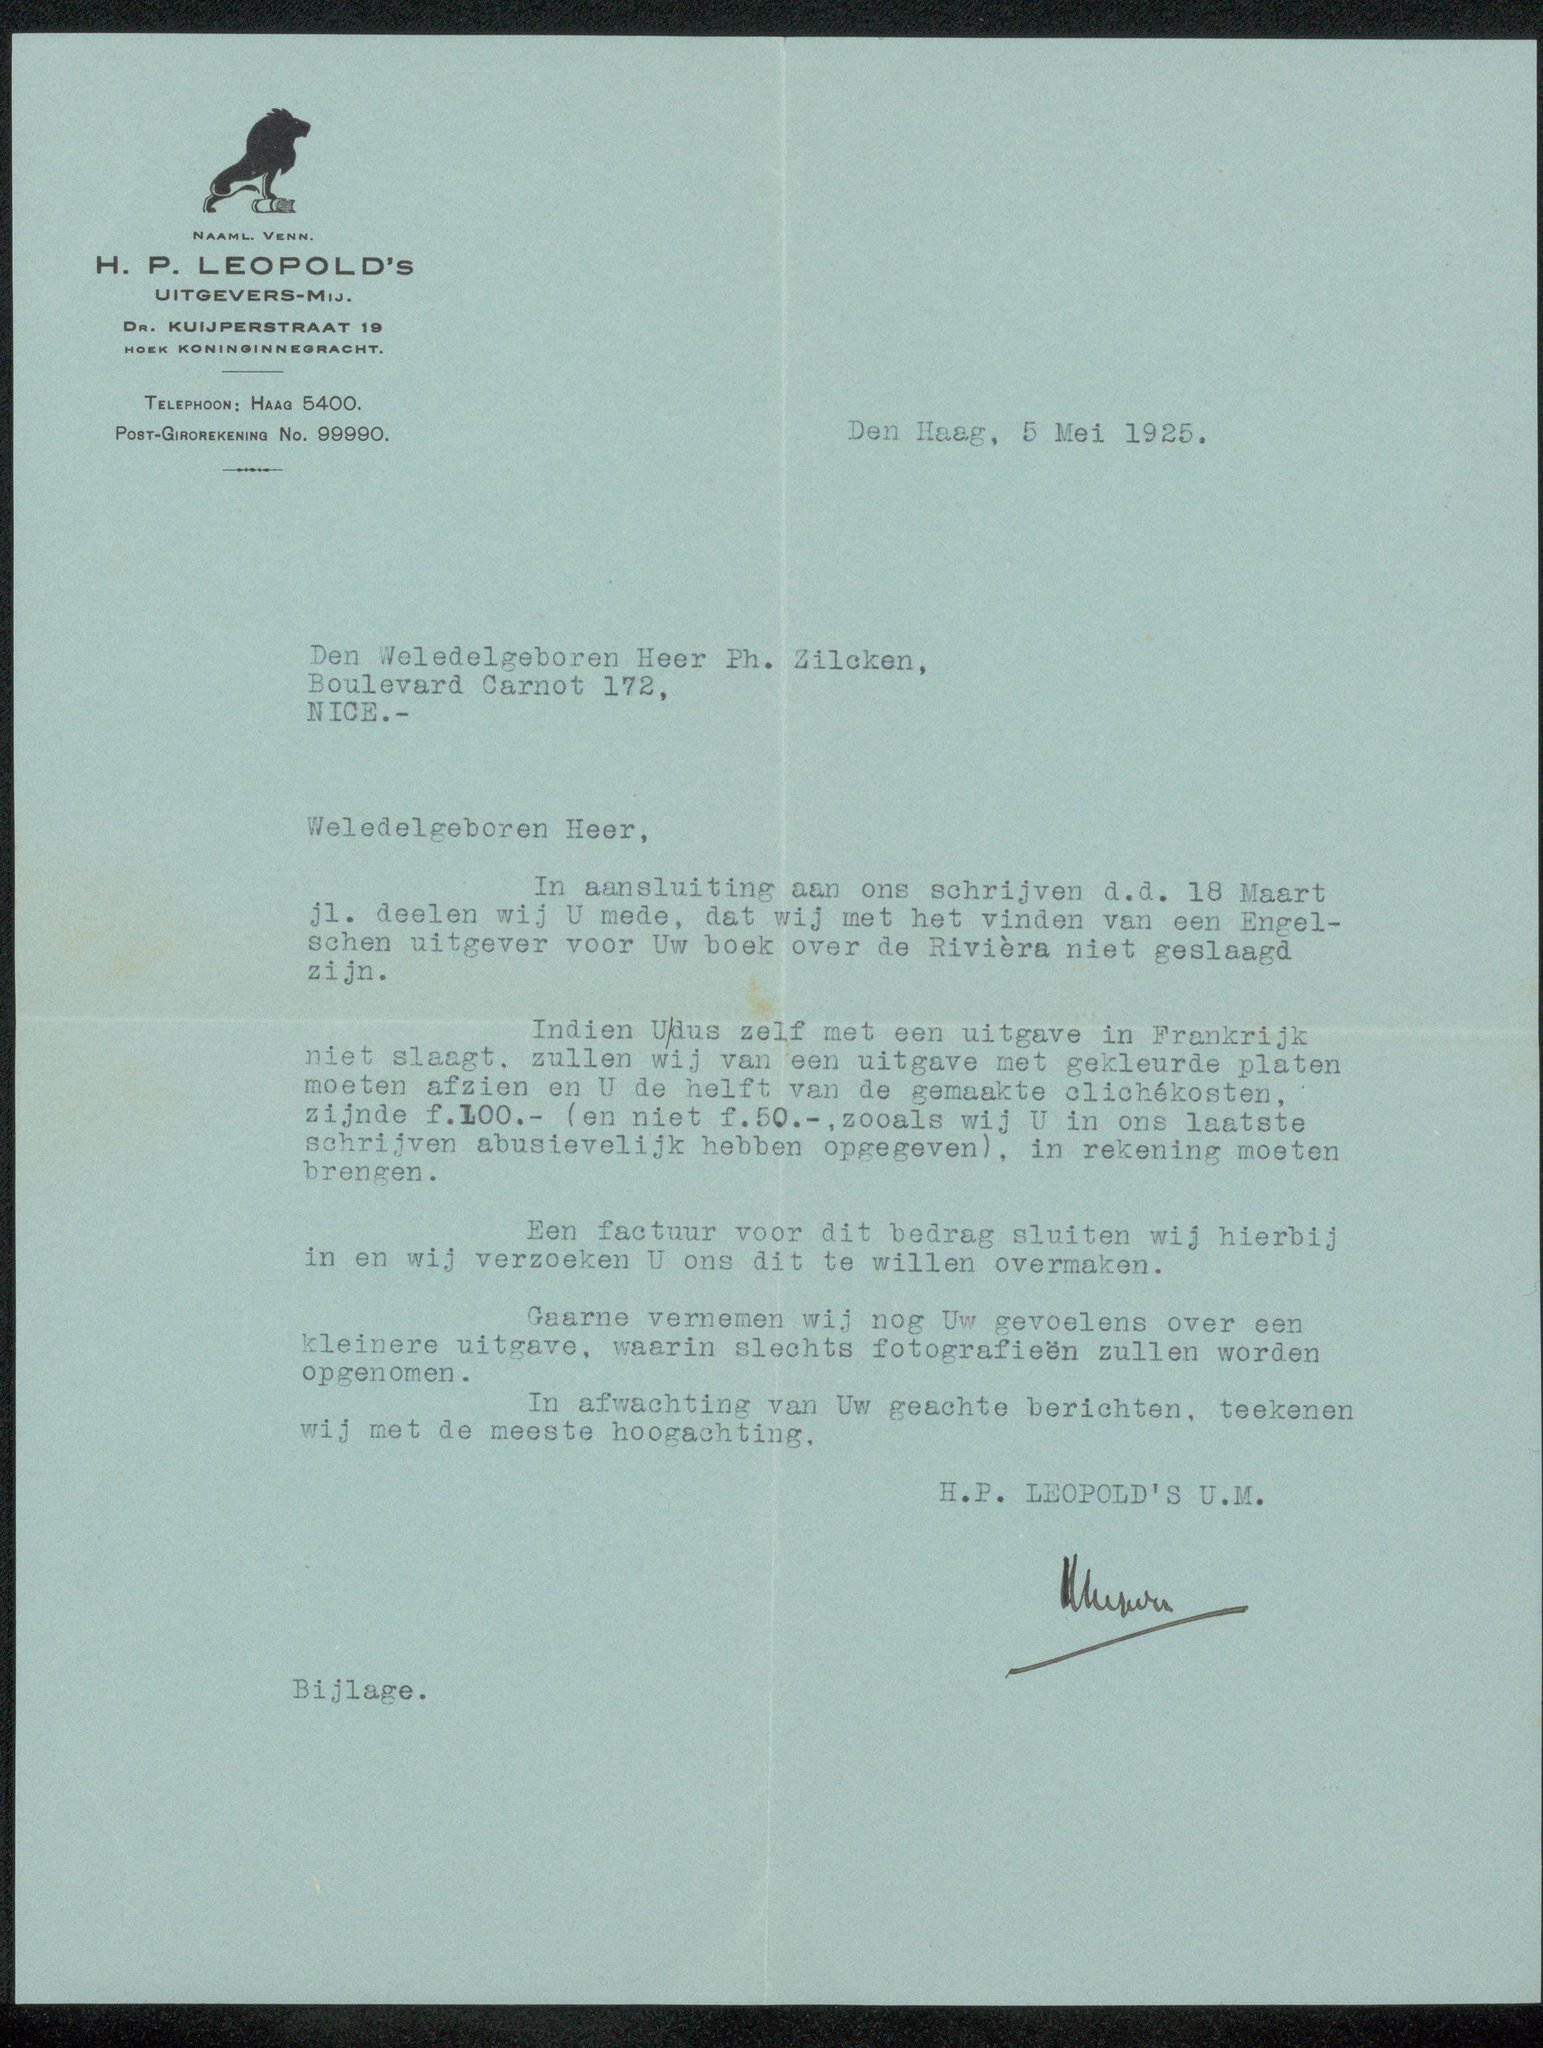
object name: letter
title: Brief aan Philip Zilcken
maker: Anonymous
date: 1925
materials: ink, paper, pencil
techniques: pen, printing, typewriting, writing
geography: the hague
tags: painter, draughtsman, philip zilcken, photography, cinematography, money, printed matter, france, england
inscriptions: collector's mark: ‘RPK’, seal: ‘De Witte Duivel/ VAN DE Zwarte Zee’, name: ‘N.V. H.P. Leopold's Uitgev. Mij.’, watermark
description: Rekening RP-D-1982-43-LEOPOLD(H.P.)-4B is verstuurd als bijlage bij deze brief.